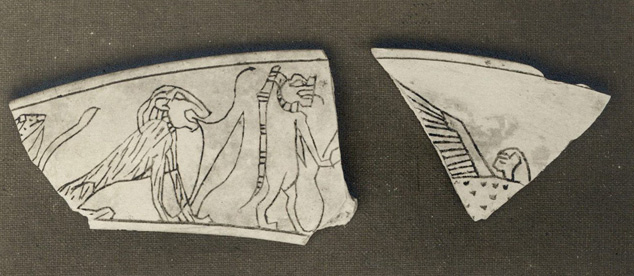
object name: magic knife fragment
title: Magic knife fragments (2)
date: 1981-1640 BCE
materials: ivory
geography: egypt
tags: animals